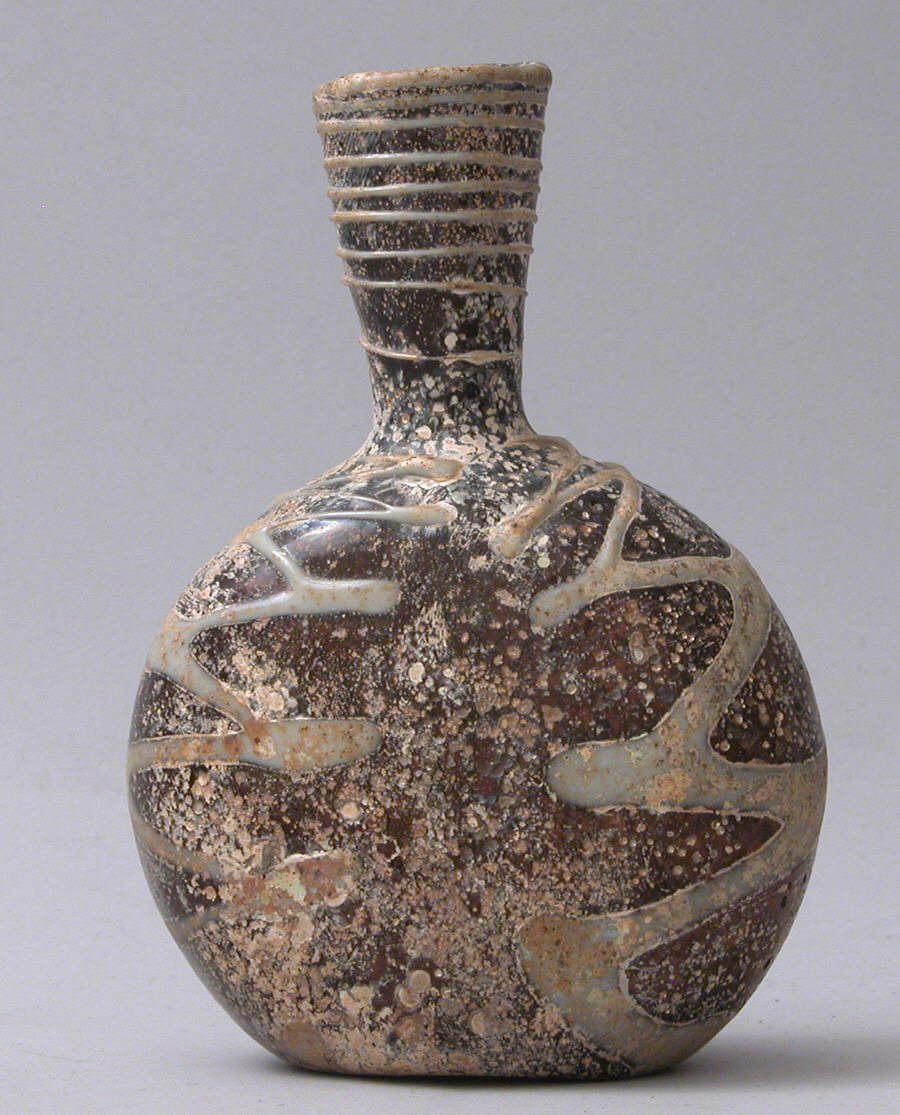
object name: bottle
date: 1201-1400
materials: glass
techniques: glassblowing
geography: syria